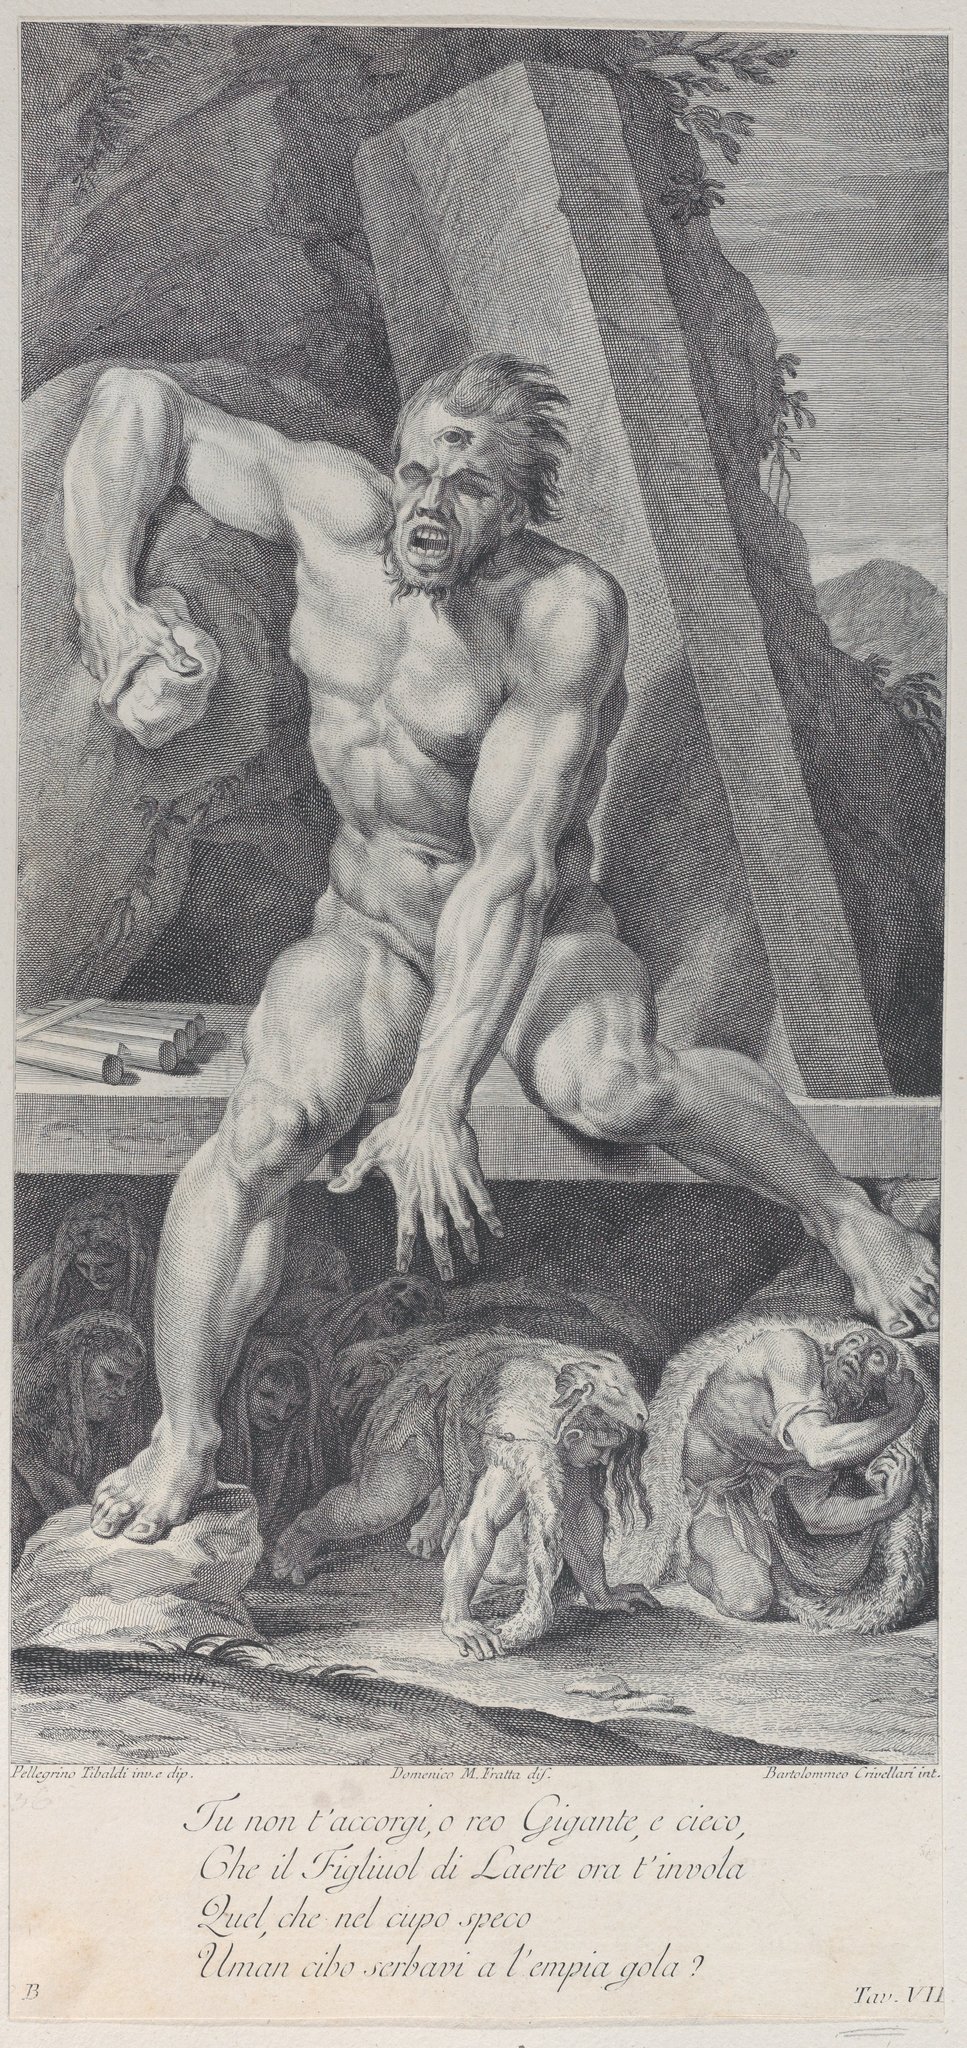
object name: print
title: Plate 7: the blinded Polyphemus, guarding the entrance of his cavern, with Ulysses and his companions escaping below by covering themselves with ram skins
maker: bartolomeo crivellari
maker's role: artist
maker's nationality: italian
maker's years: 1700-1800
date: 1756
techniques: engraving, etching